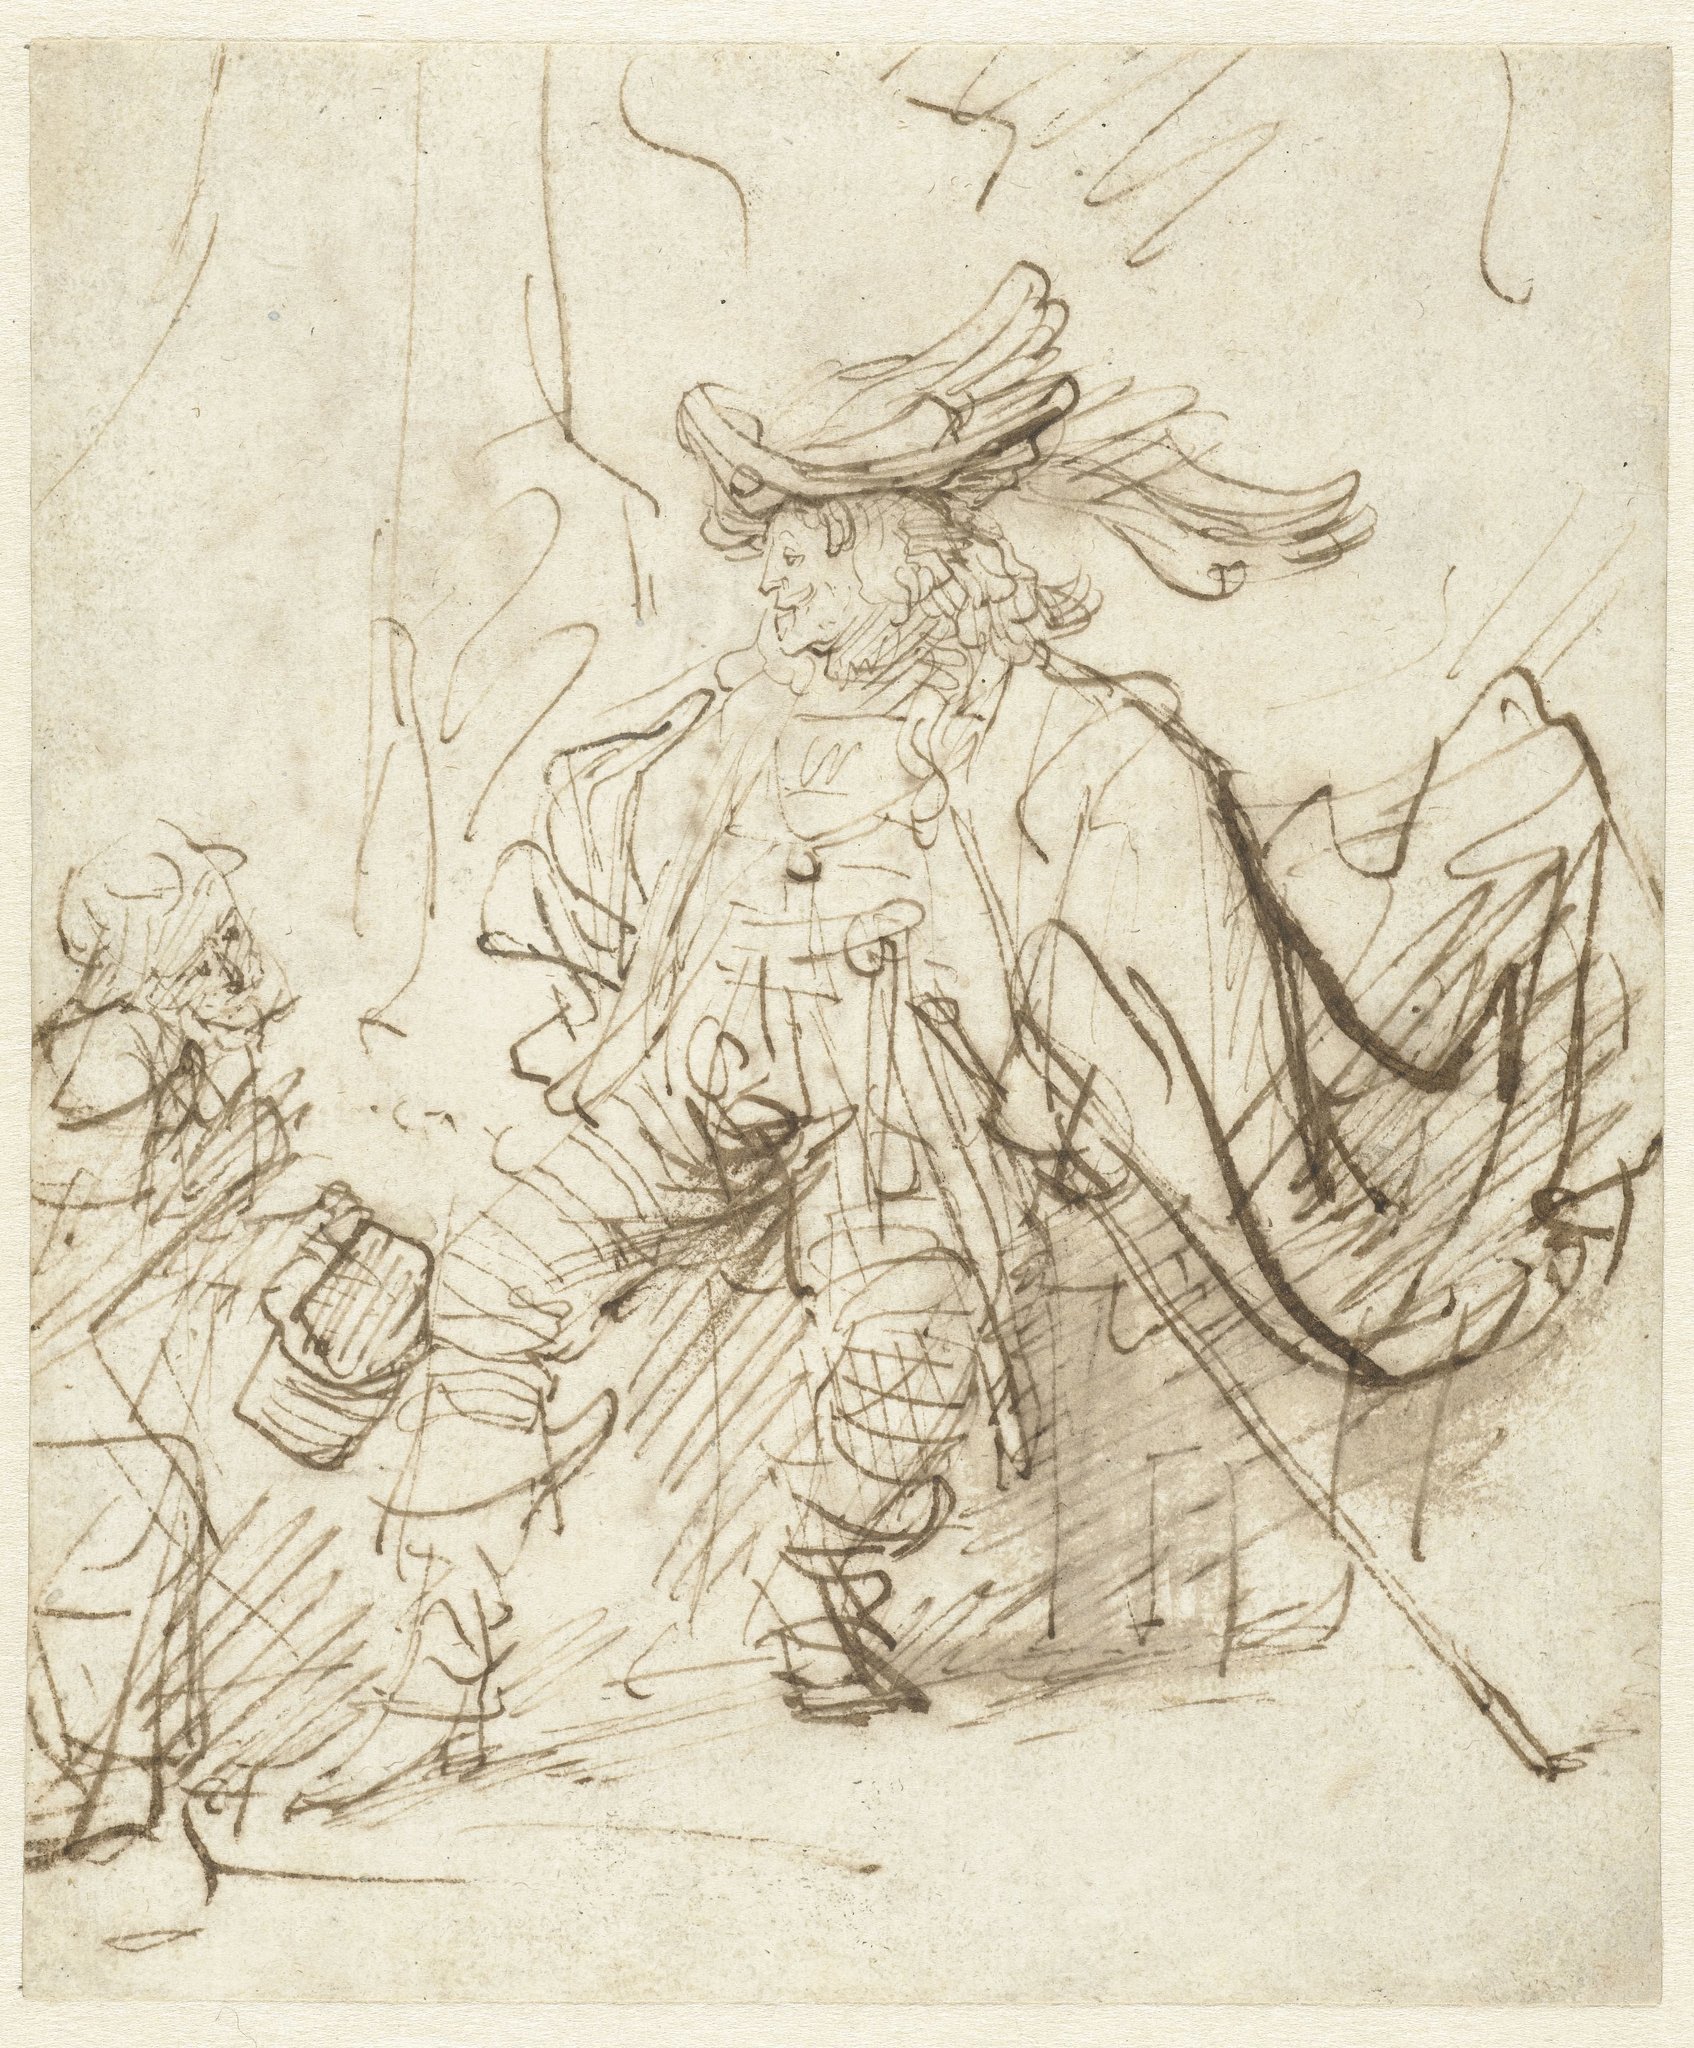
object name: drawing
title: Seated Actor in the Role of Capitano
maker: rembrandt van rijn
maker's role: draughtsman, painter, print maker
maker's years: 1606-1669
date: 1634-1636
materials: paper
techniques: brush, pen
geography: amsterdam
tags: types in 'commedia dell'arte' (with name)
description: Rembrandt’s interest in the theatre lasted throughout his entire career. The costume worn by this actor closely resembles that of the flamboyant, blusterous Capitano, a character in the Italian commedia dell’arte performances and popular in Dutch farces. The woman at the left, an old procuress, offers him an open bag. The Dutch word for ‘bag’ (‘tas’) at the time also meant ‘prostitute’.